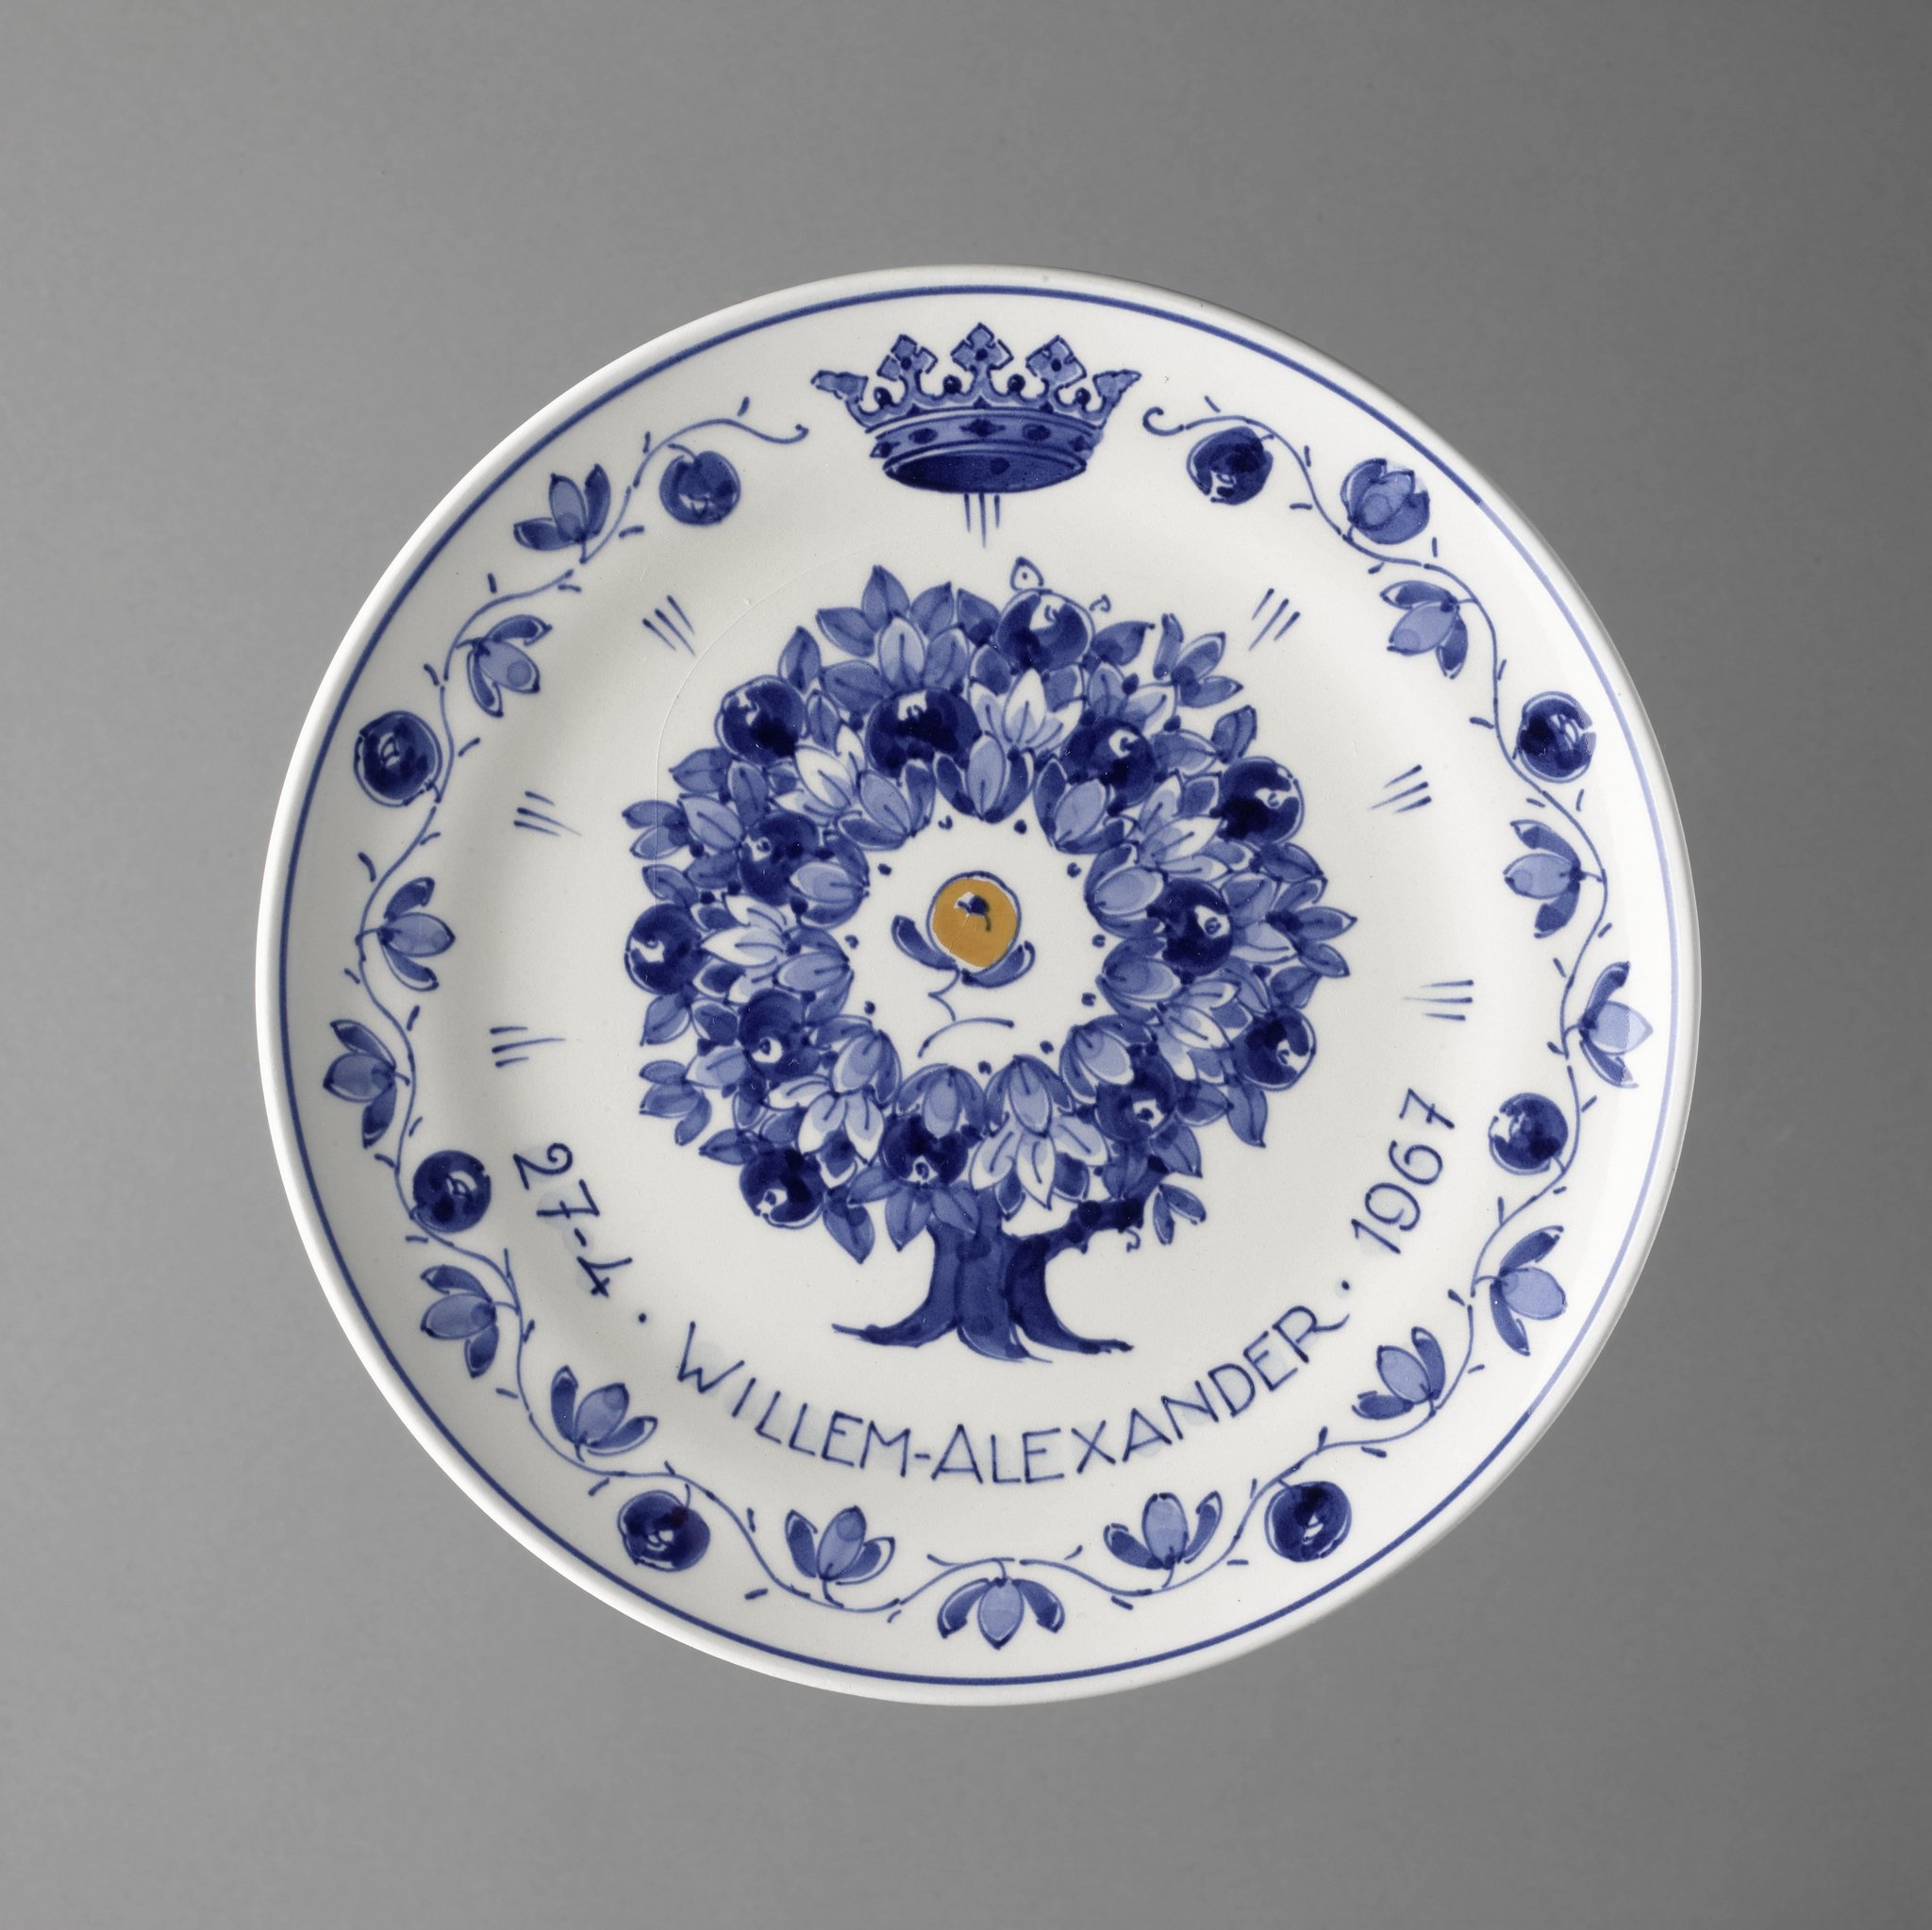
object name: herinneringsbord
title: Geboorte van Willem Alexander, kroonprins der Nederlanden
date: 1967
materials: earthenware, glaze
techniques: painted, vitrification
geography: delft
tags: willem-alexander (koning der nederlanden)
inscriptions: title: ‘27 - 4 . WILLEM-ALEXANDER . 1967’, factory mark: ‘JT Delft’, mark: ‘RD. 1808’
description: Bord, blauw geschilderd met afbeelding van een gekroonde oranjeboom met in het midden één oranje appel. Hieronder opschrift. Achterzijde twee blauwe randen en v.z.v. twee gaatjes en ijzerdraad om bord op te hangen. Gemerkt.